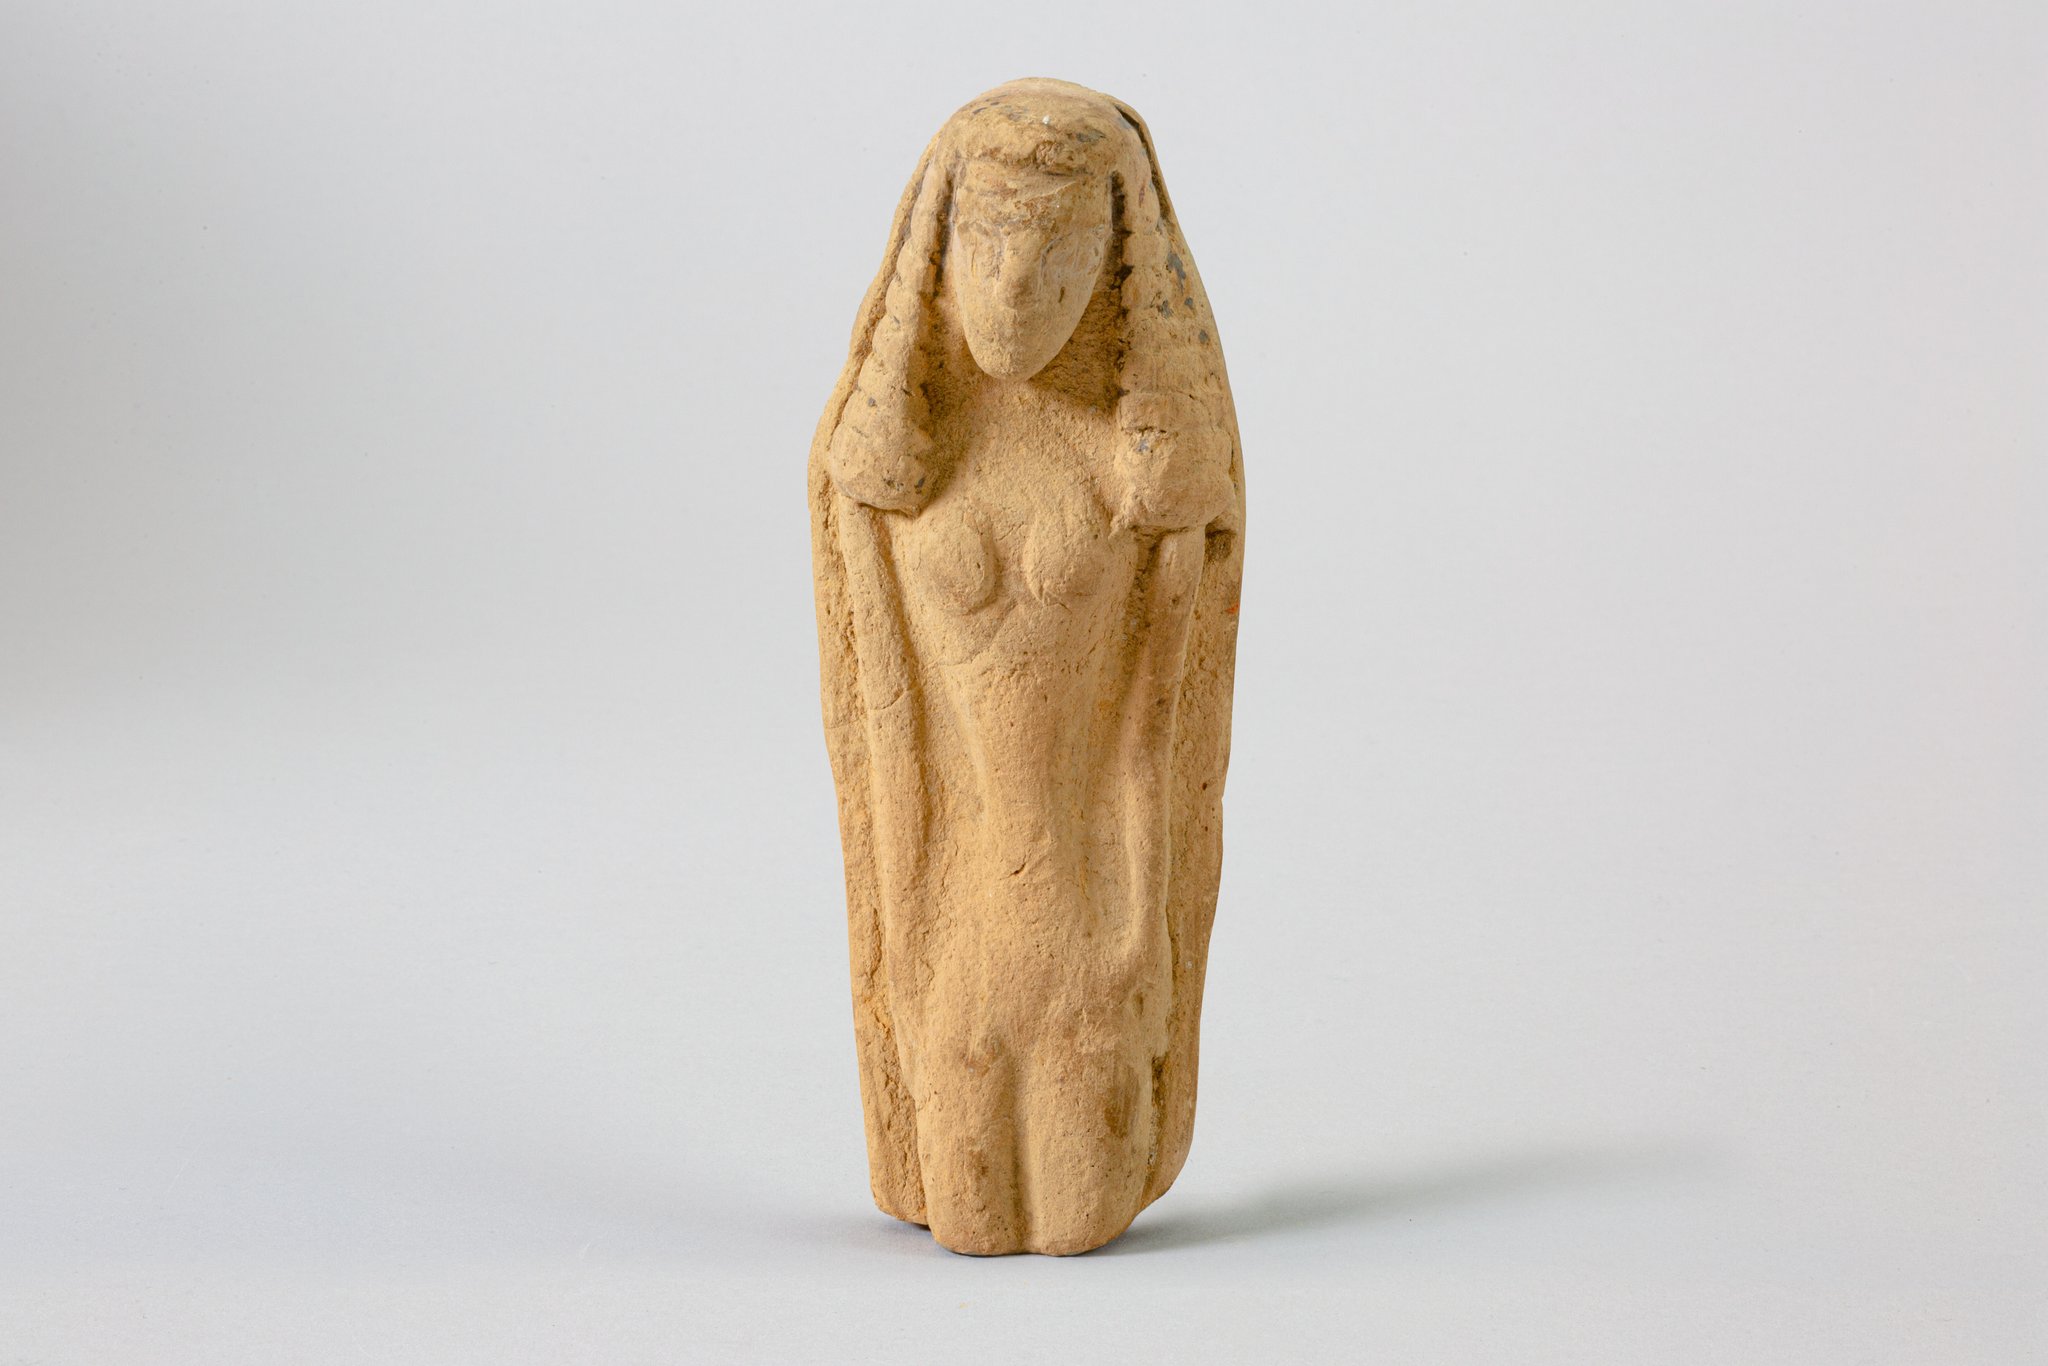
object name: statuette of a woman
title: Terracotta statuette of a nude woman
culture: greek, cretan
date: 700-601 BCE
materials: terracotta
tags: women